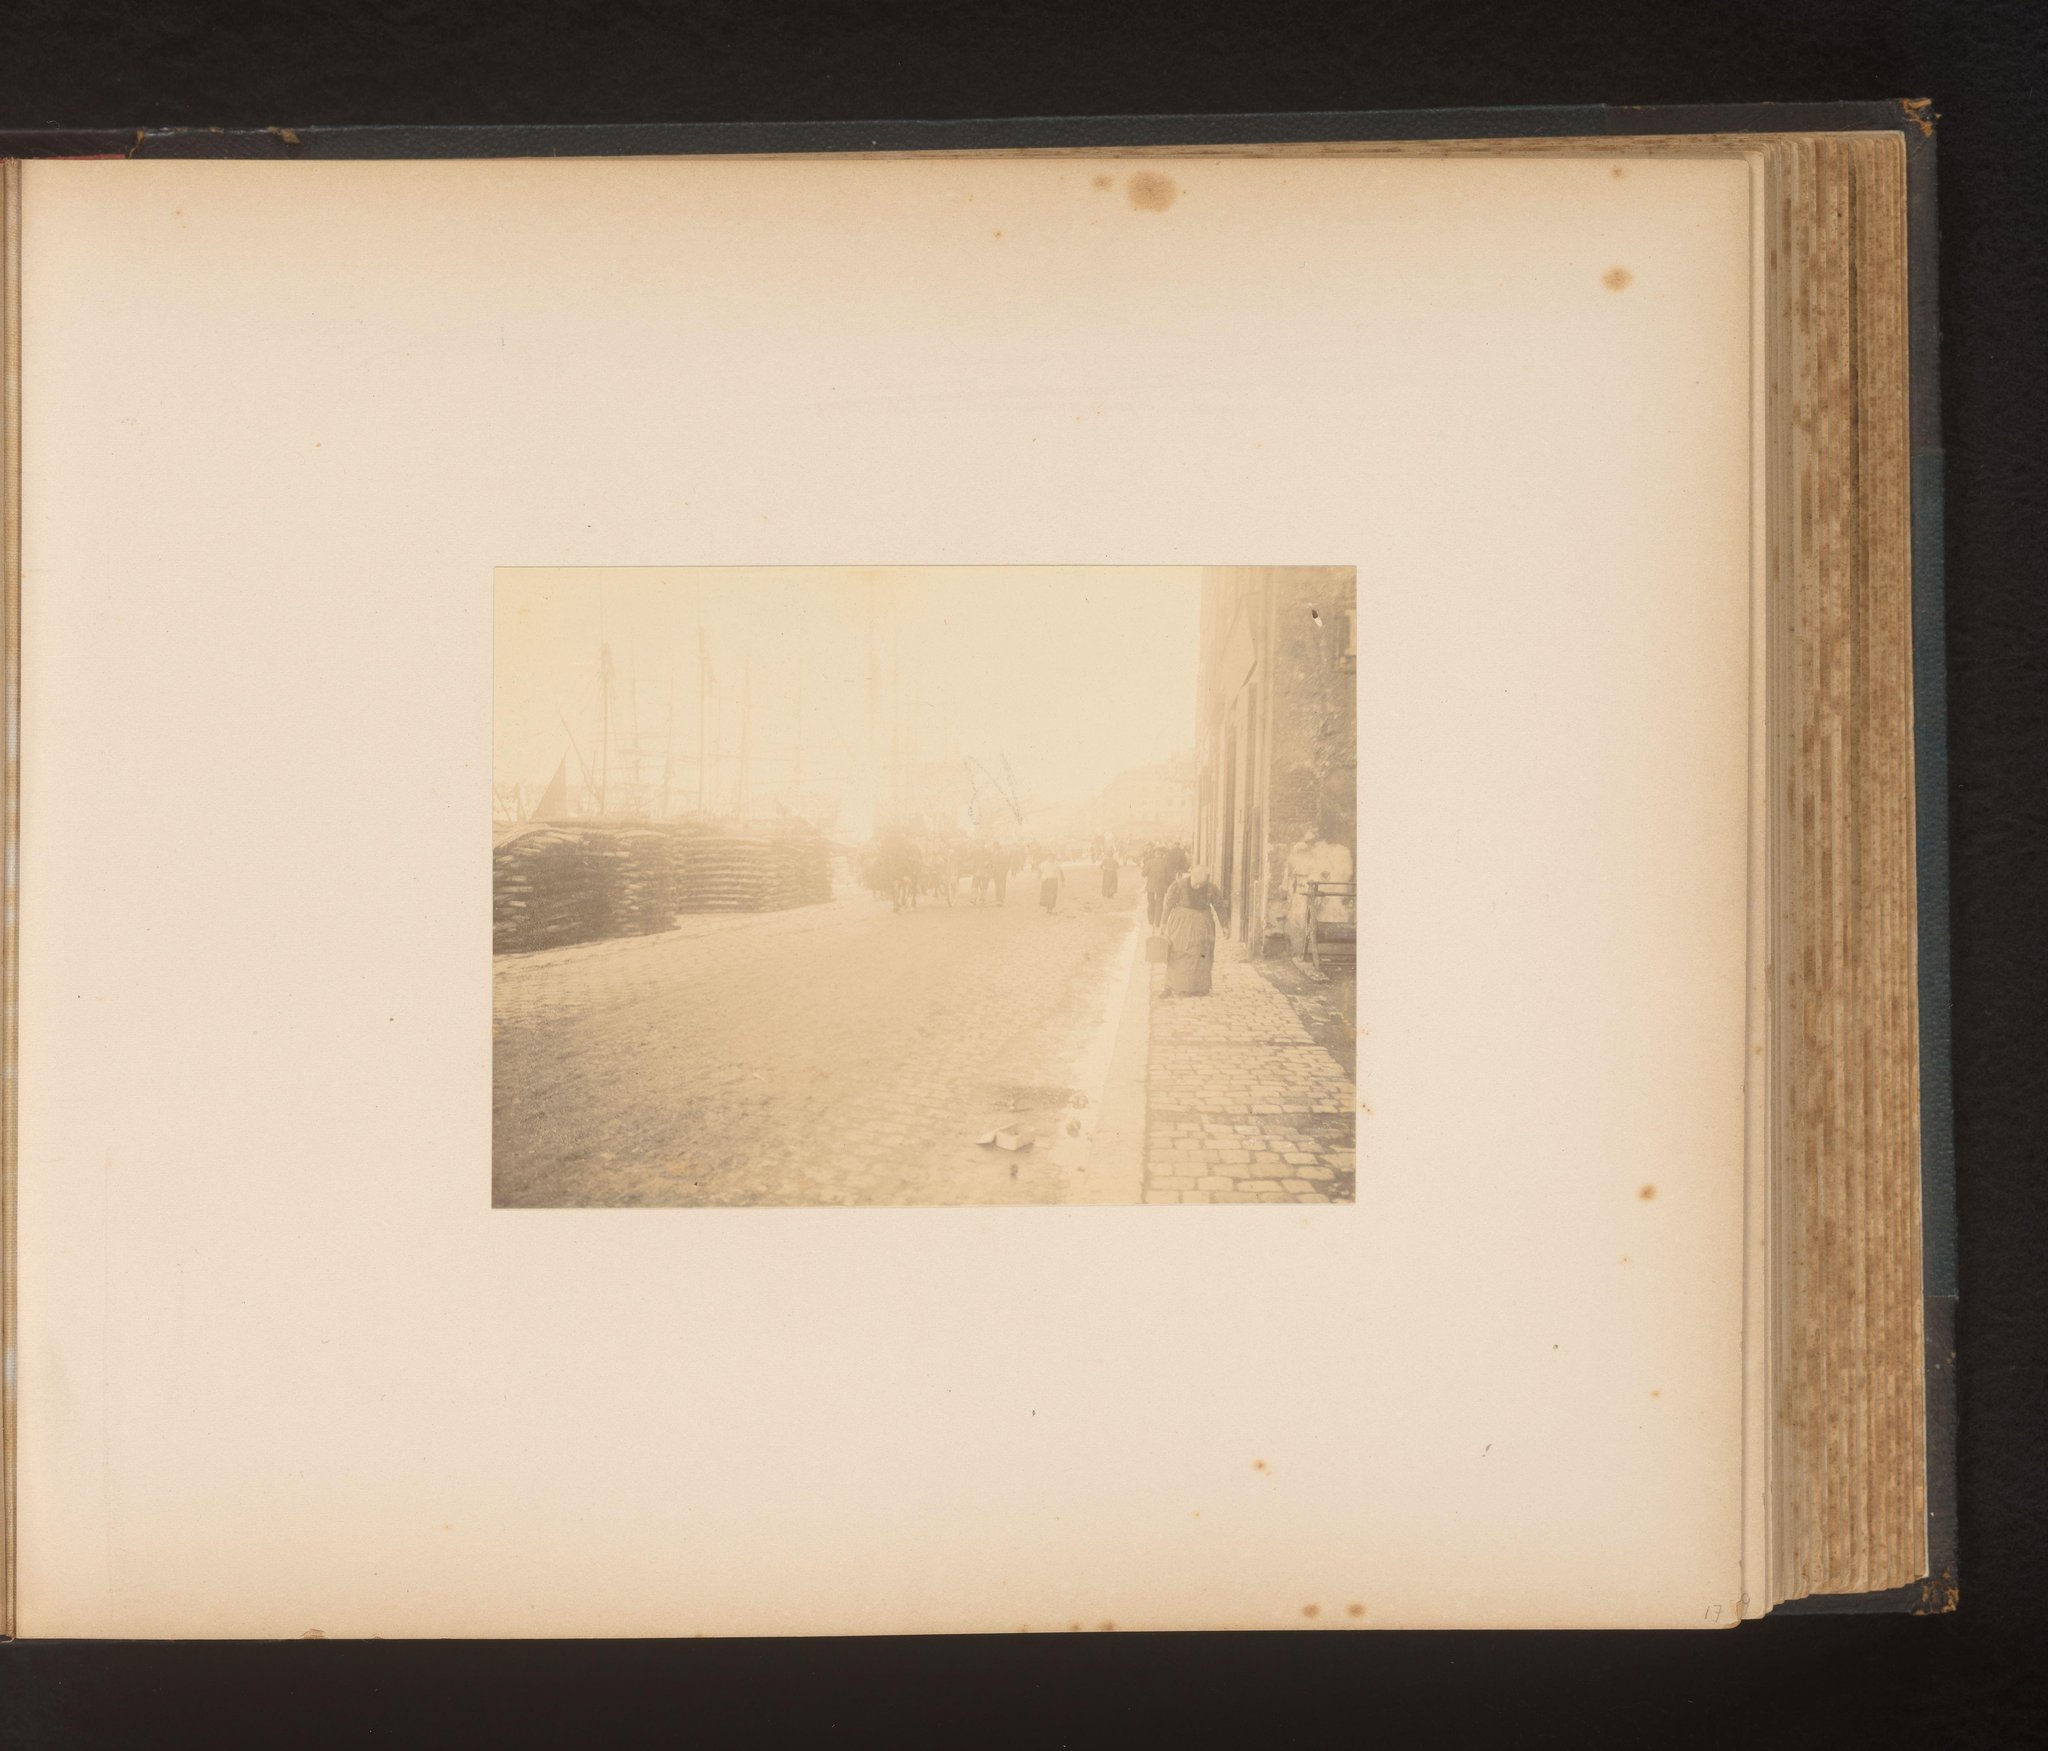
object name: album leaf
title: Gezicht op een kade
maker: Anonymous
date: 1880-1920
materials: cardboard, photographic support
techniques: gelatin silver print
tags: harbour, ships (in general), pier, quay, wharf, france